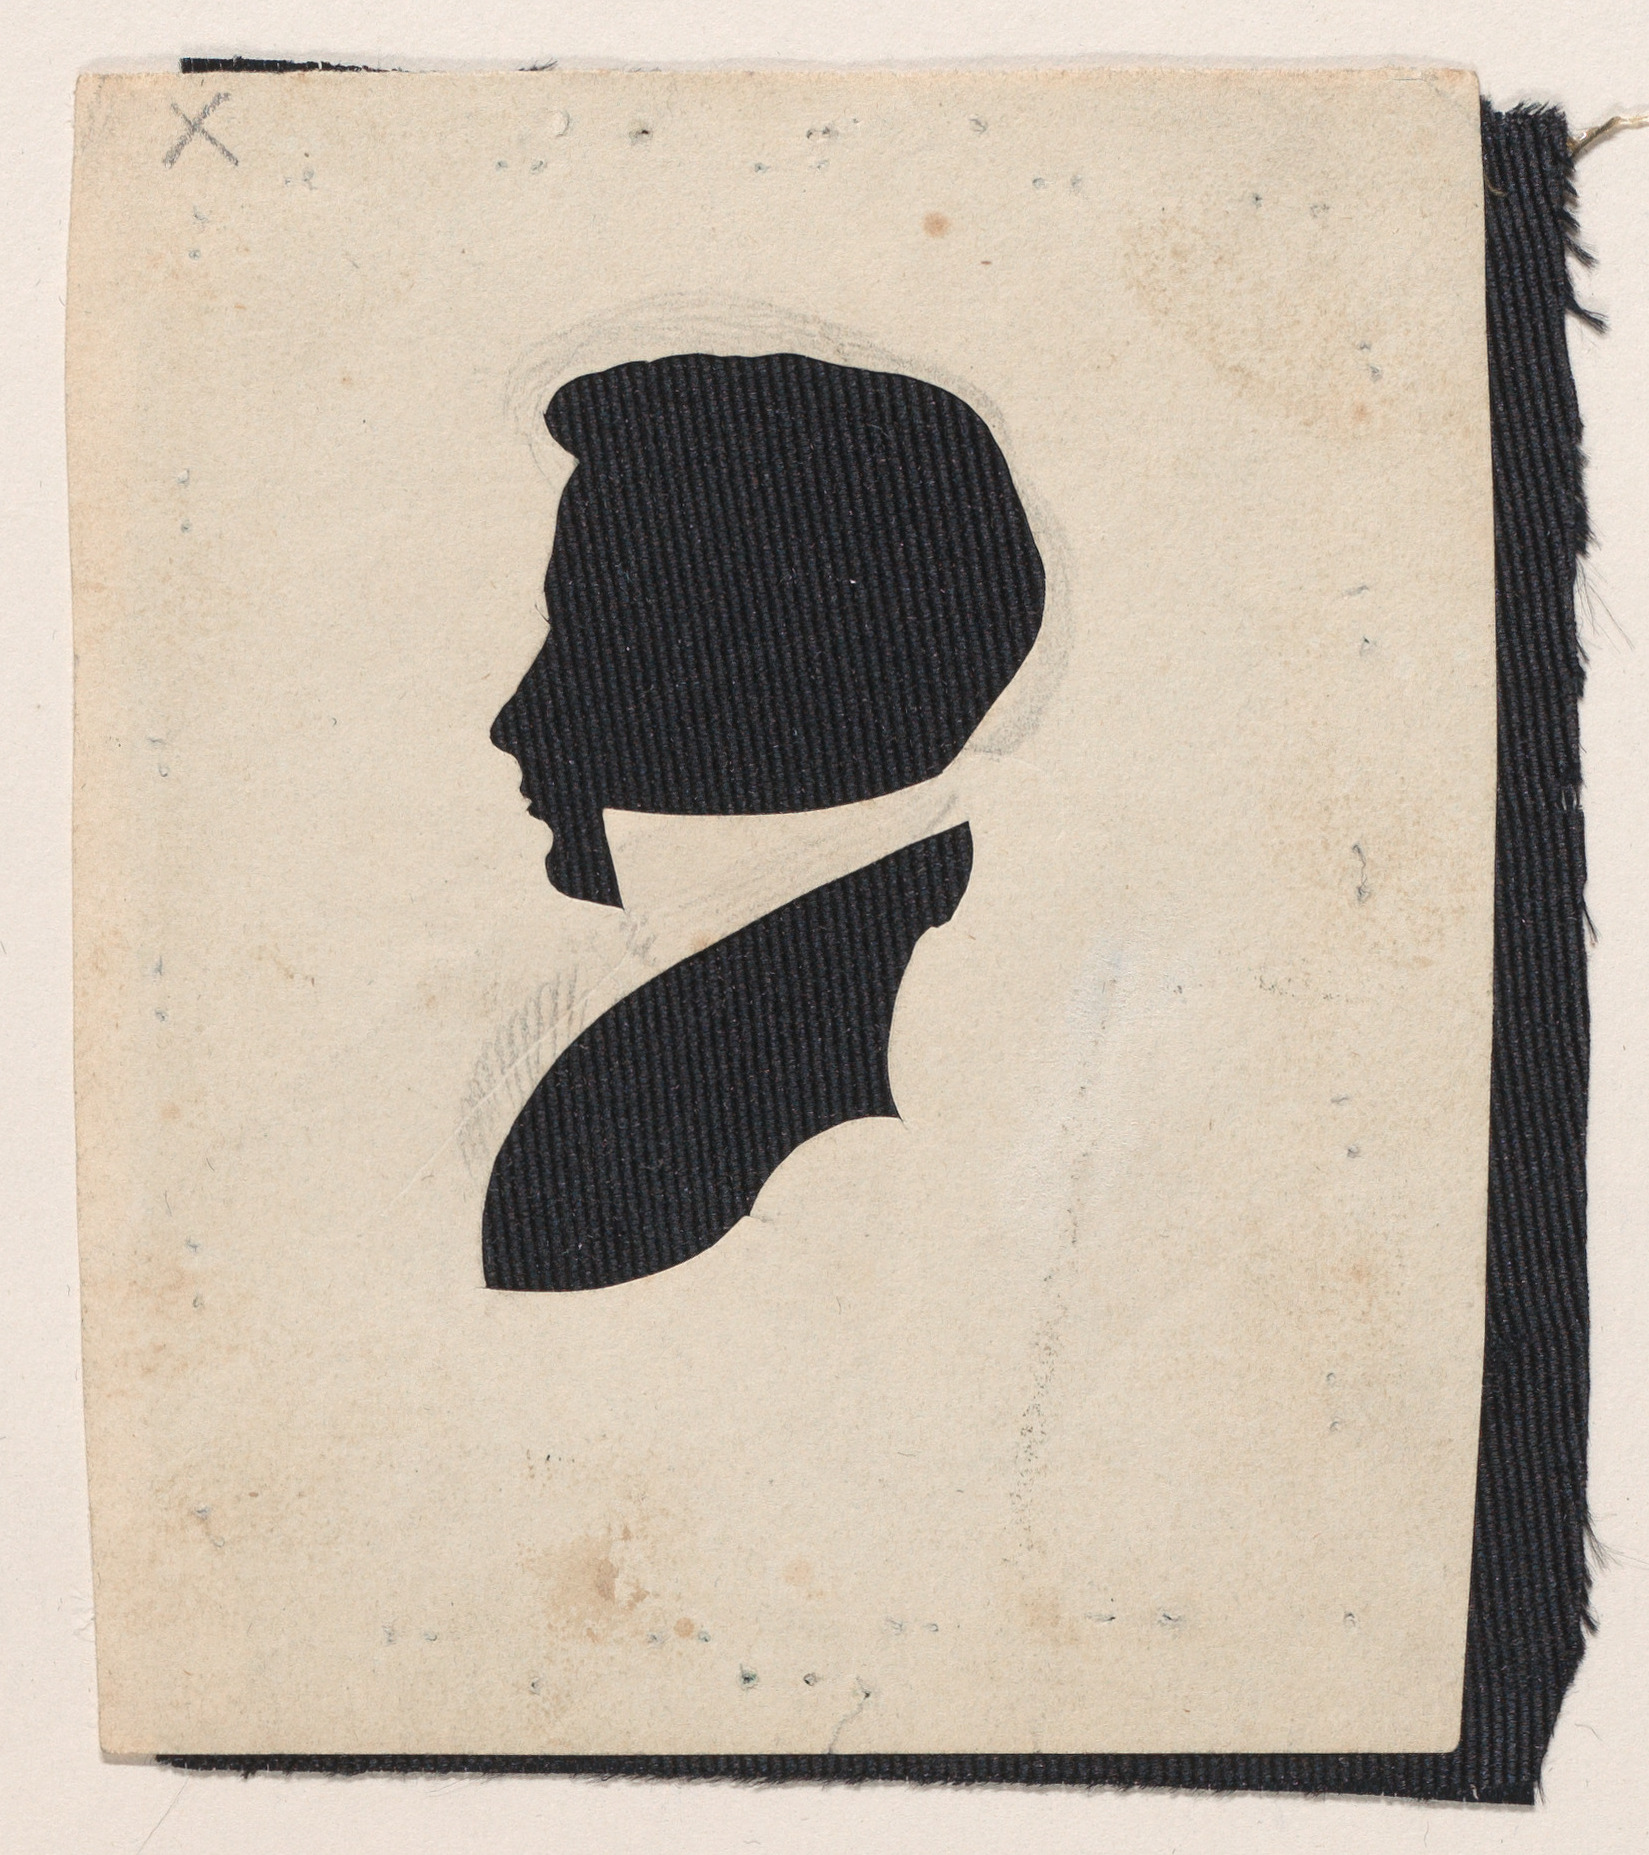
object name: cut paper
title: Silhouette of Giles H. Case, to left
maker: william chamberlain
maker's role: artist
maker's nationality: american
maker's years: 1790-1890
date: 1824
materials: paper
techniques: cutting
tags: men